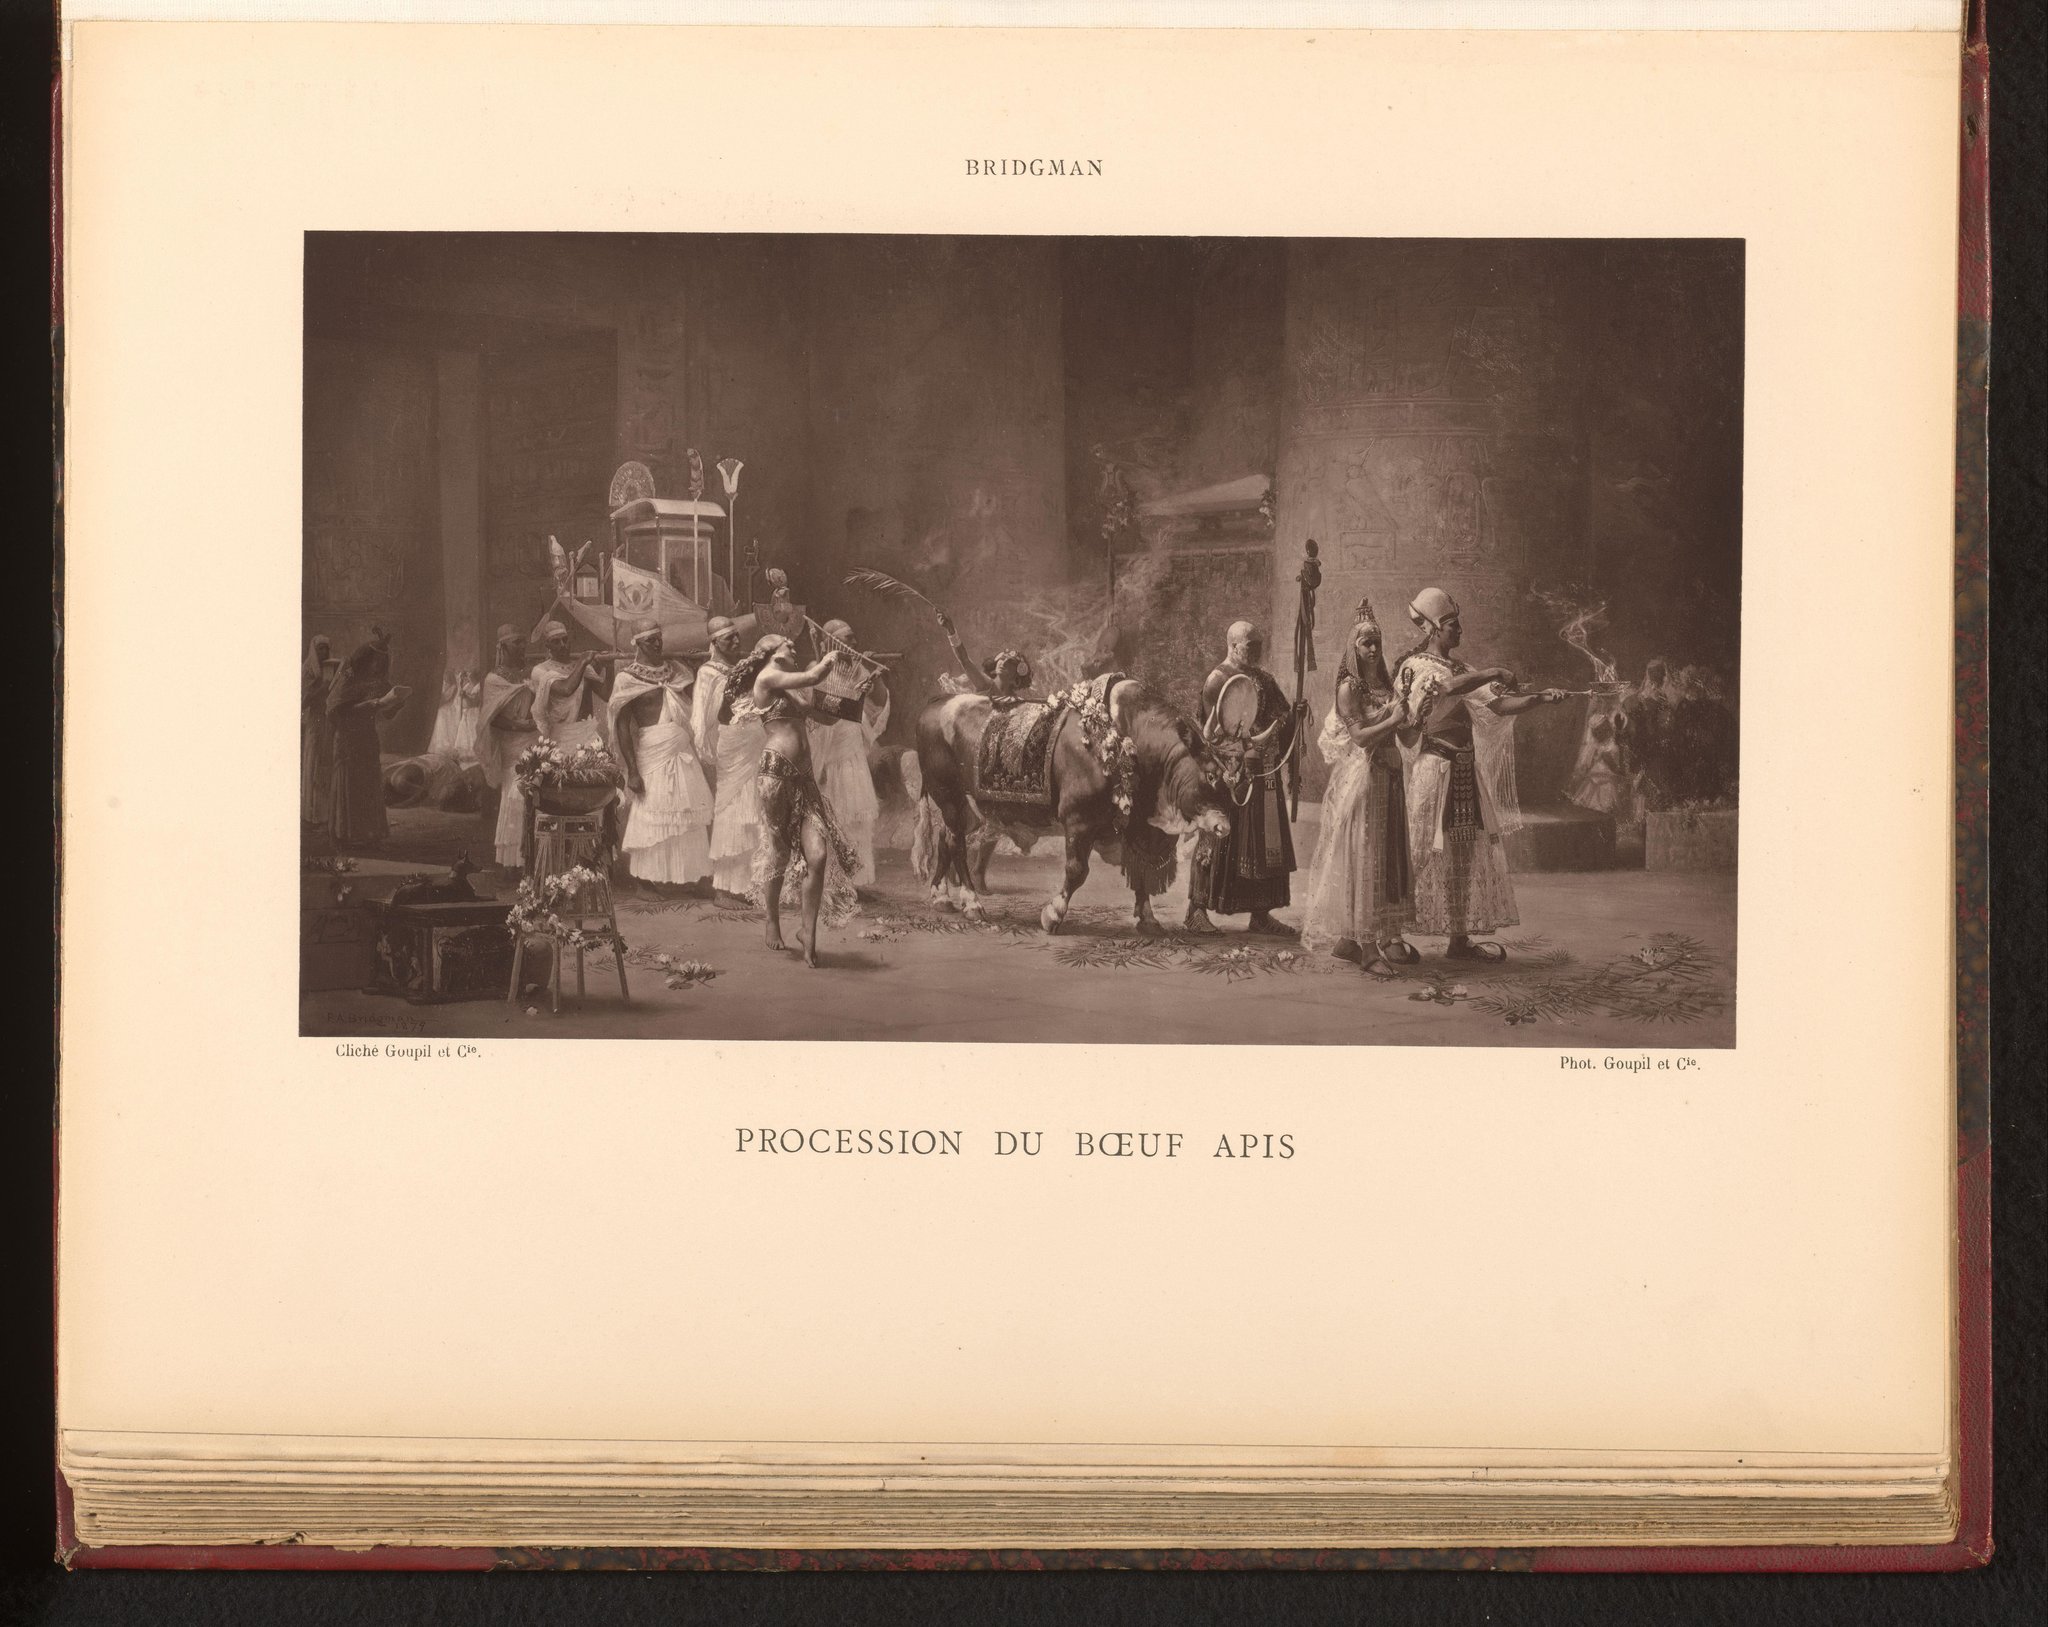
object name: photomechanical print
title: Fotoreproductie van het schilderij 'Procession du boeuf Apis' door Frederick Arthur Bridgman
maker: frederick arthur bridgman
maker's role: painter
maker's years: 1847-1928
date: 1877-1882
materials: paper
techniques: woodburytype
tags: ritual practices ~ egyptian religion, ox